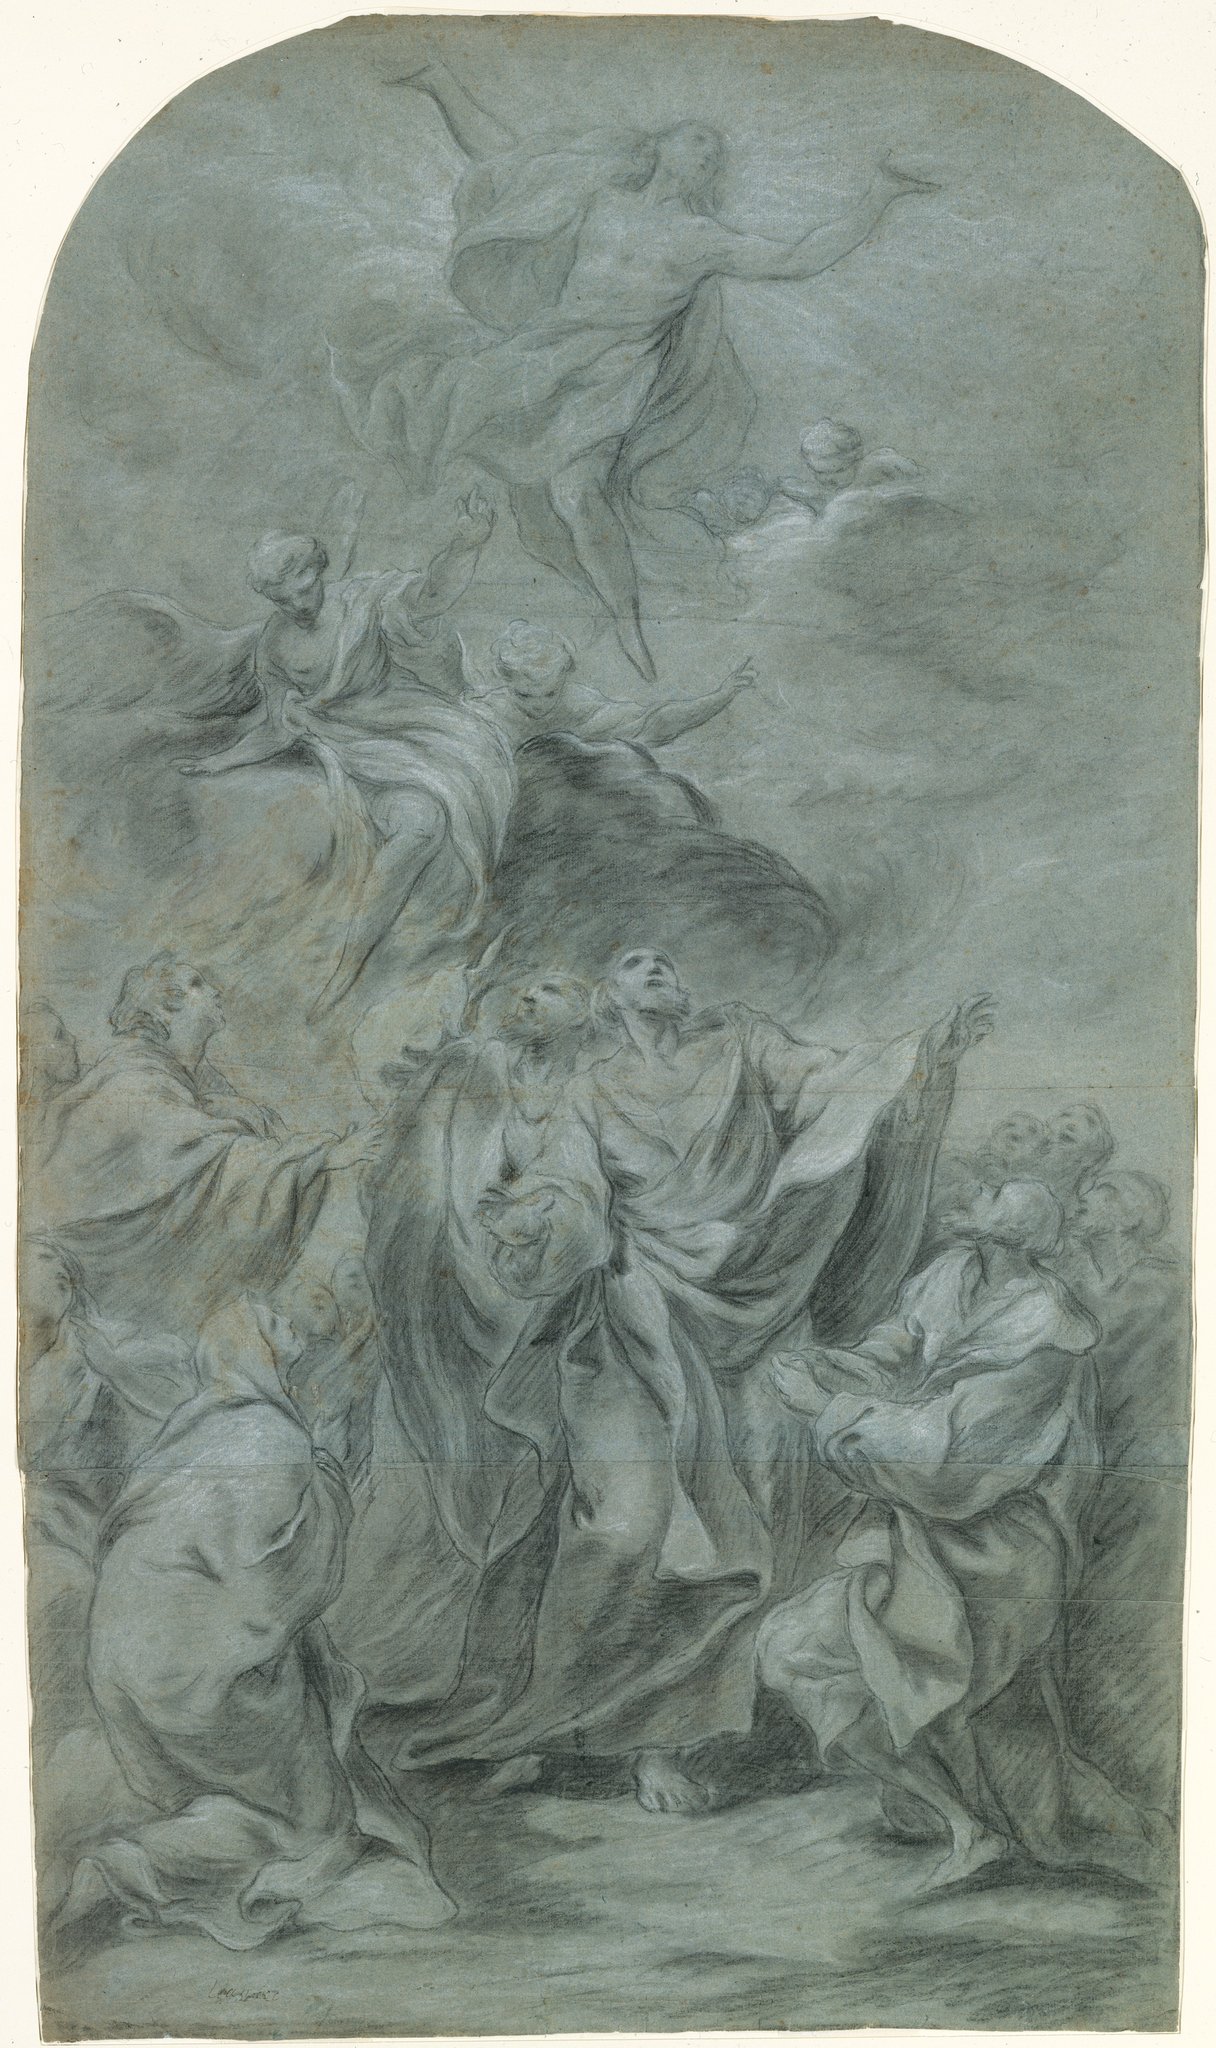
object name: drawing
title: The Ascension of Christ (recto); Head of a Bearded Man Looking Down (verso)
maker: pierre charles trémolières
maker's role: artist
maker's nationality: french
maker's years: 1703-1739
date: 1737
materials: chalk, charcoal, paper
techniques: heightening, stumping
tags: men,women,christ